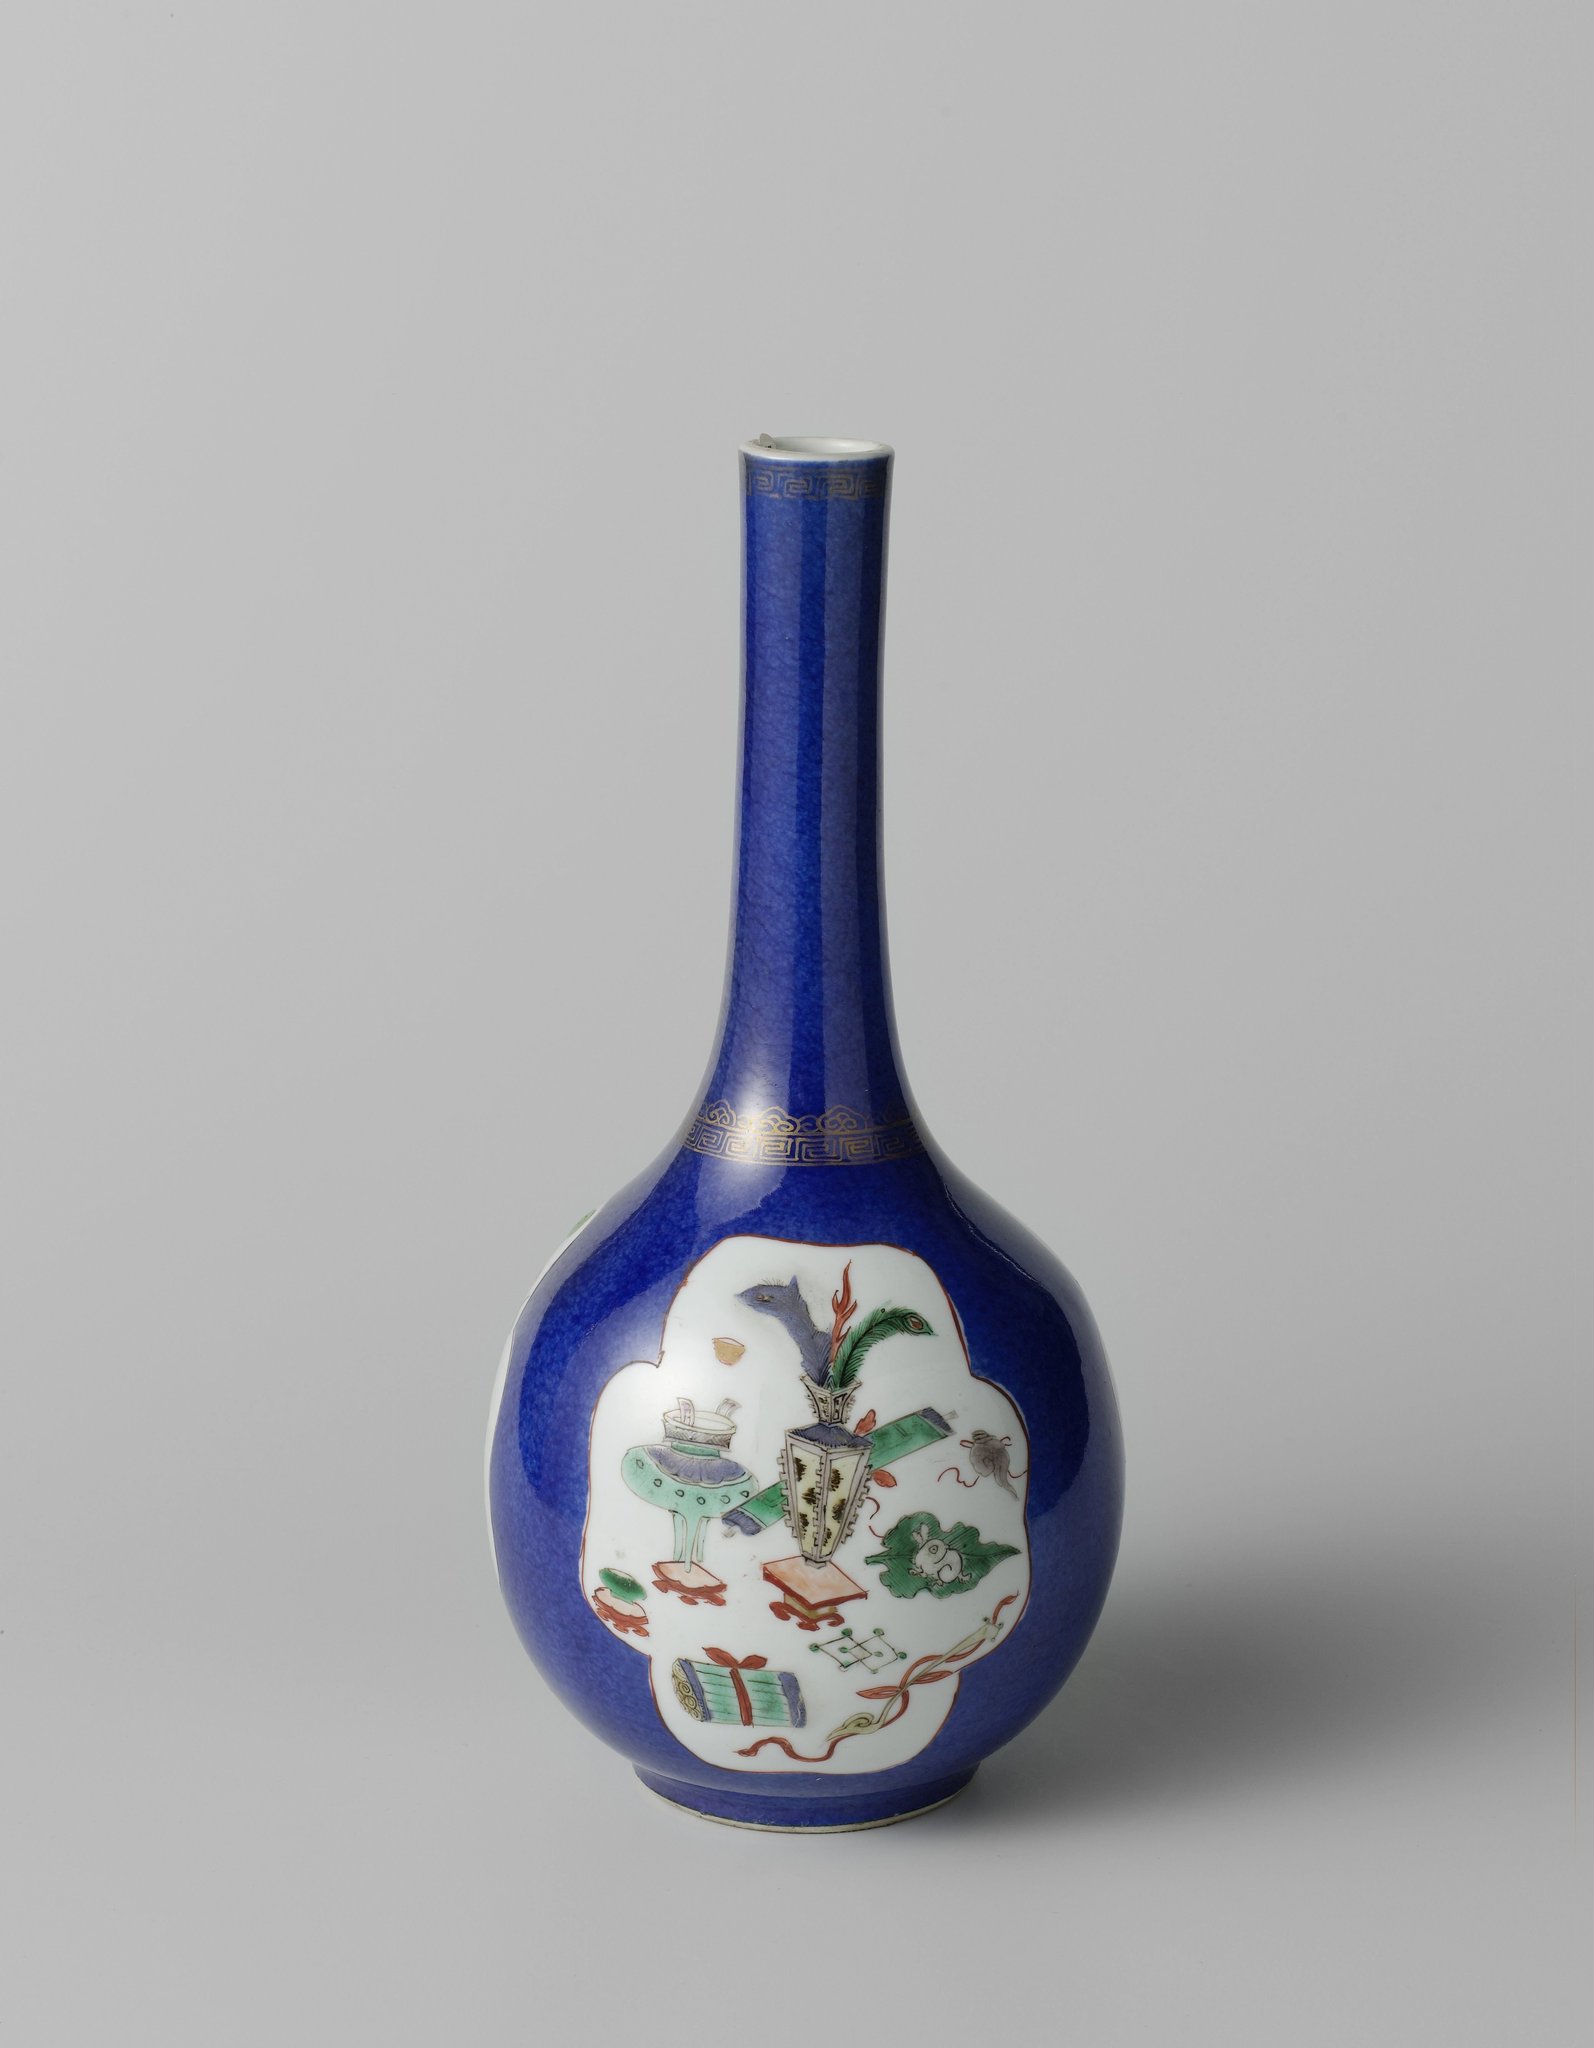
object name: vase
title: Pear-shaped bottle vase with powder blue, flower sprays and antiquities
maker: Anonymous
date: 1700-1724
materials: cobalt, glaze, gold, paint, porcelain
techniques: firing, gilding, turning, vitrification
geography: china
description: AK-NM-6368 Drie flessen • Bleu poudré porselein met verte • Onderdeel van Royers porseleincollectie • Mogelijk afkomstig van Susanna Louise Huygens • Gepubliceerd Jörg 2011, nr. 99. Door de iets diepere kleur blauw van het gesprenkelde blauw in de achtergrond en de met zorg geschilderde banden rond de hals lijken deze vazen verwant aan de fraaie dekselpot AK-NM-6362. Maar de velden zijn hier wel een stuk sneller en onzorgvuldiger geschilderd. Bovendien is hier blauw email gebruikt, een aanwijzing voor een iets latere datering. De kostbaarheden zijn een veel voorkomend motief op Kangxi-porselein, niet alleen bij het bleu poudré. Voor een toelichting, zie de opmerkingen bij AK-NM-6769. Waarschijnlijk kocht Royer deze vazen in 1786 uit de nalatenschap van zijn oudtante Susanna Louise Huygens (1714-1785). Huygens kocht toen veel porselein en dat zal ook hebben gegolden voor: ‘Drie flessen als vooren [hoog blauw met compartimenten waarin gecouleurde bloemen] met goude vergulde kransjes om de halzen.’ De omschrijving past nauwkeurig (gouden kransjes!) op deze drie vazen die nog steeds in de collectie Royer aanwezig zijn. Poudré was ook geliefd onder verzamelaars in de periode dat Chinees porselein opnieuw een verzamelonderwerp werd, vanaf het eind van de 19de eeuw. Een goed voorbeeld van een verzameling uit deze periode is die van Gustaaf Hamburger (1887-1977) en zijn vrouw Clara Gerzon (1907-2007). In hun collectie is in de omvangrijke groep poudré een paar identieke flessen te vinden (Bosmans 2011, nr. 40, p. 74). Bronnen : Sarah Bosmans, ‘La collection Chinoise Hamburger : une collection caratéristique du XIXe siècle’, in : La donation Clare van Beusekom-Hamburger. Faïences et porcelaines des XVIe-XVIIe siècles (tent.cat. Ariana) Genève, 2010, pp. 52-109.